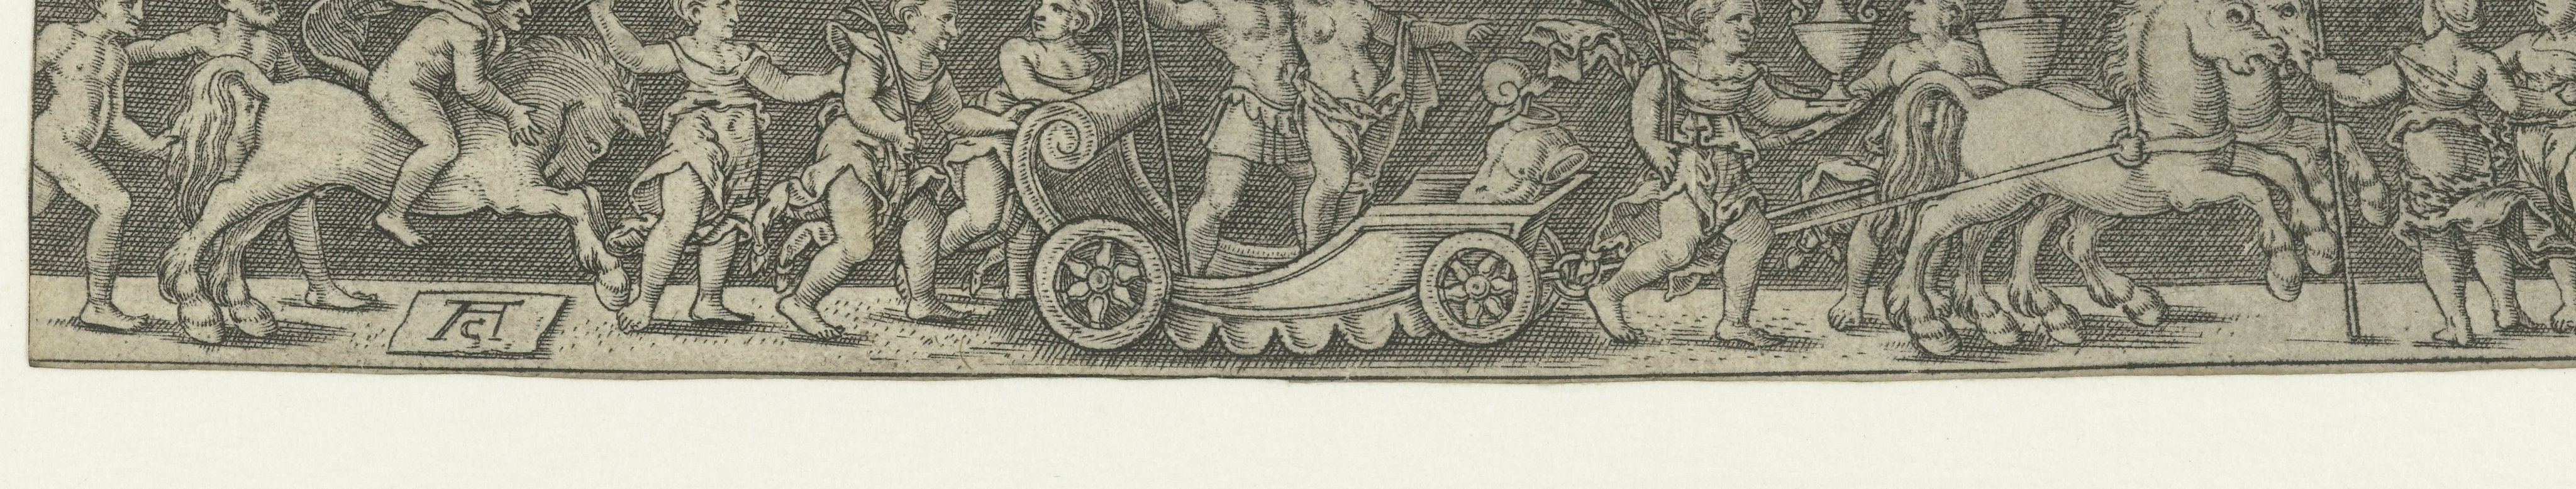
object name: print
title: Triomfwagen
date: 1520-1562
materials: paper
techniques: engraving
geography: low countries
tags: chariot, triumphal car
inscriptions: collector's mark: Lugt 2930, collector's mark: Lugt 2228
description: Triomftocht met man en vrouw op wagen, getrokken door paarden.